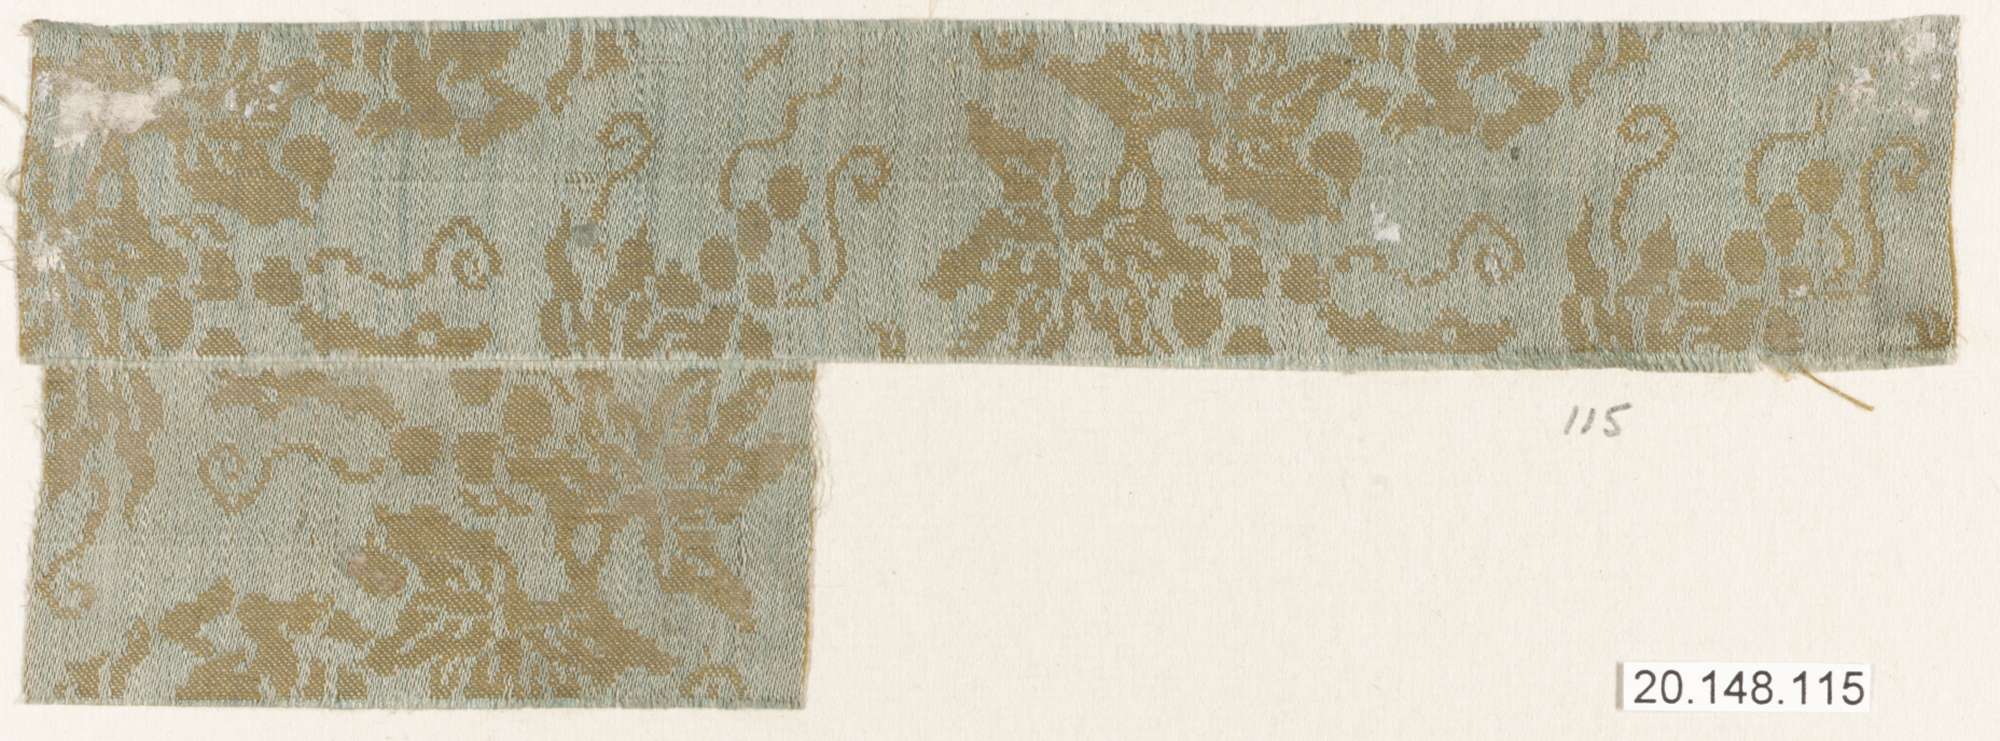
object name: piece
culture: japanese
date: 1601-1700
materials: silk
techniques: compound weave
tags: leaves